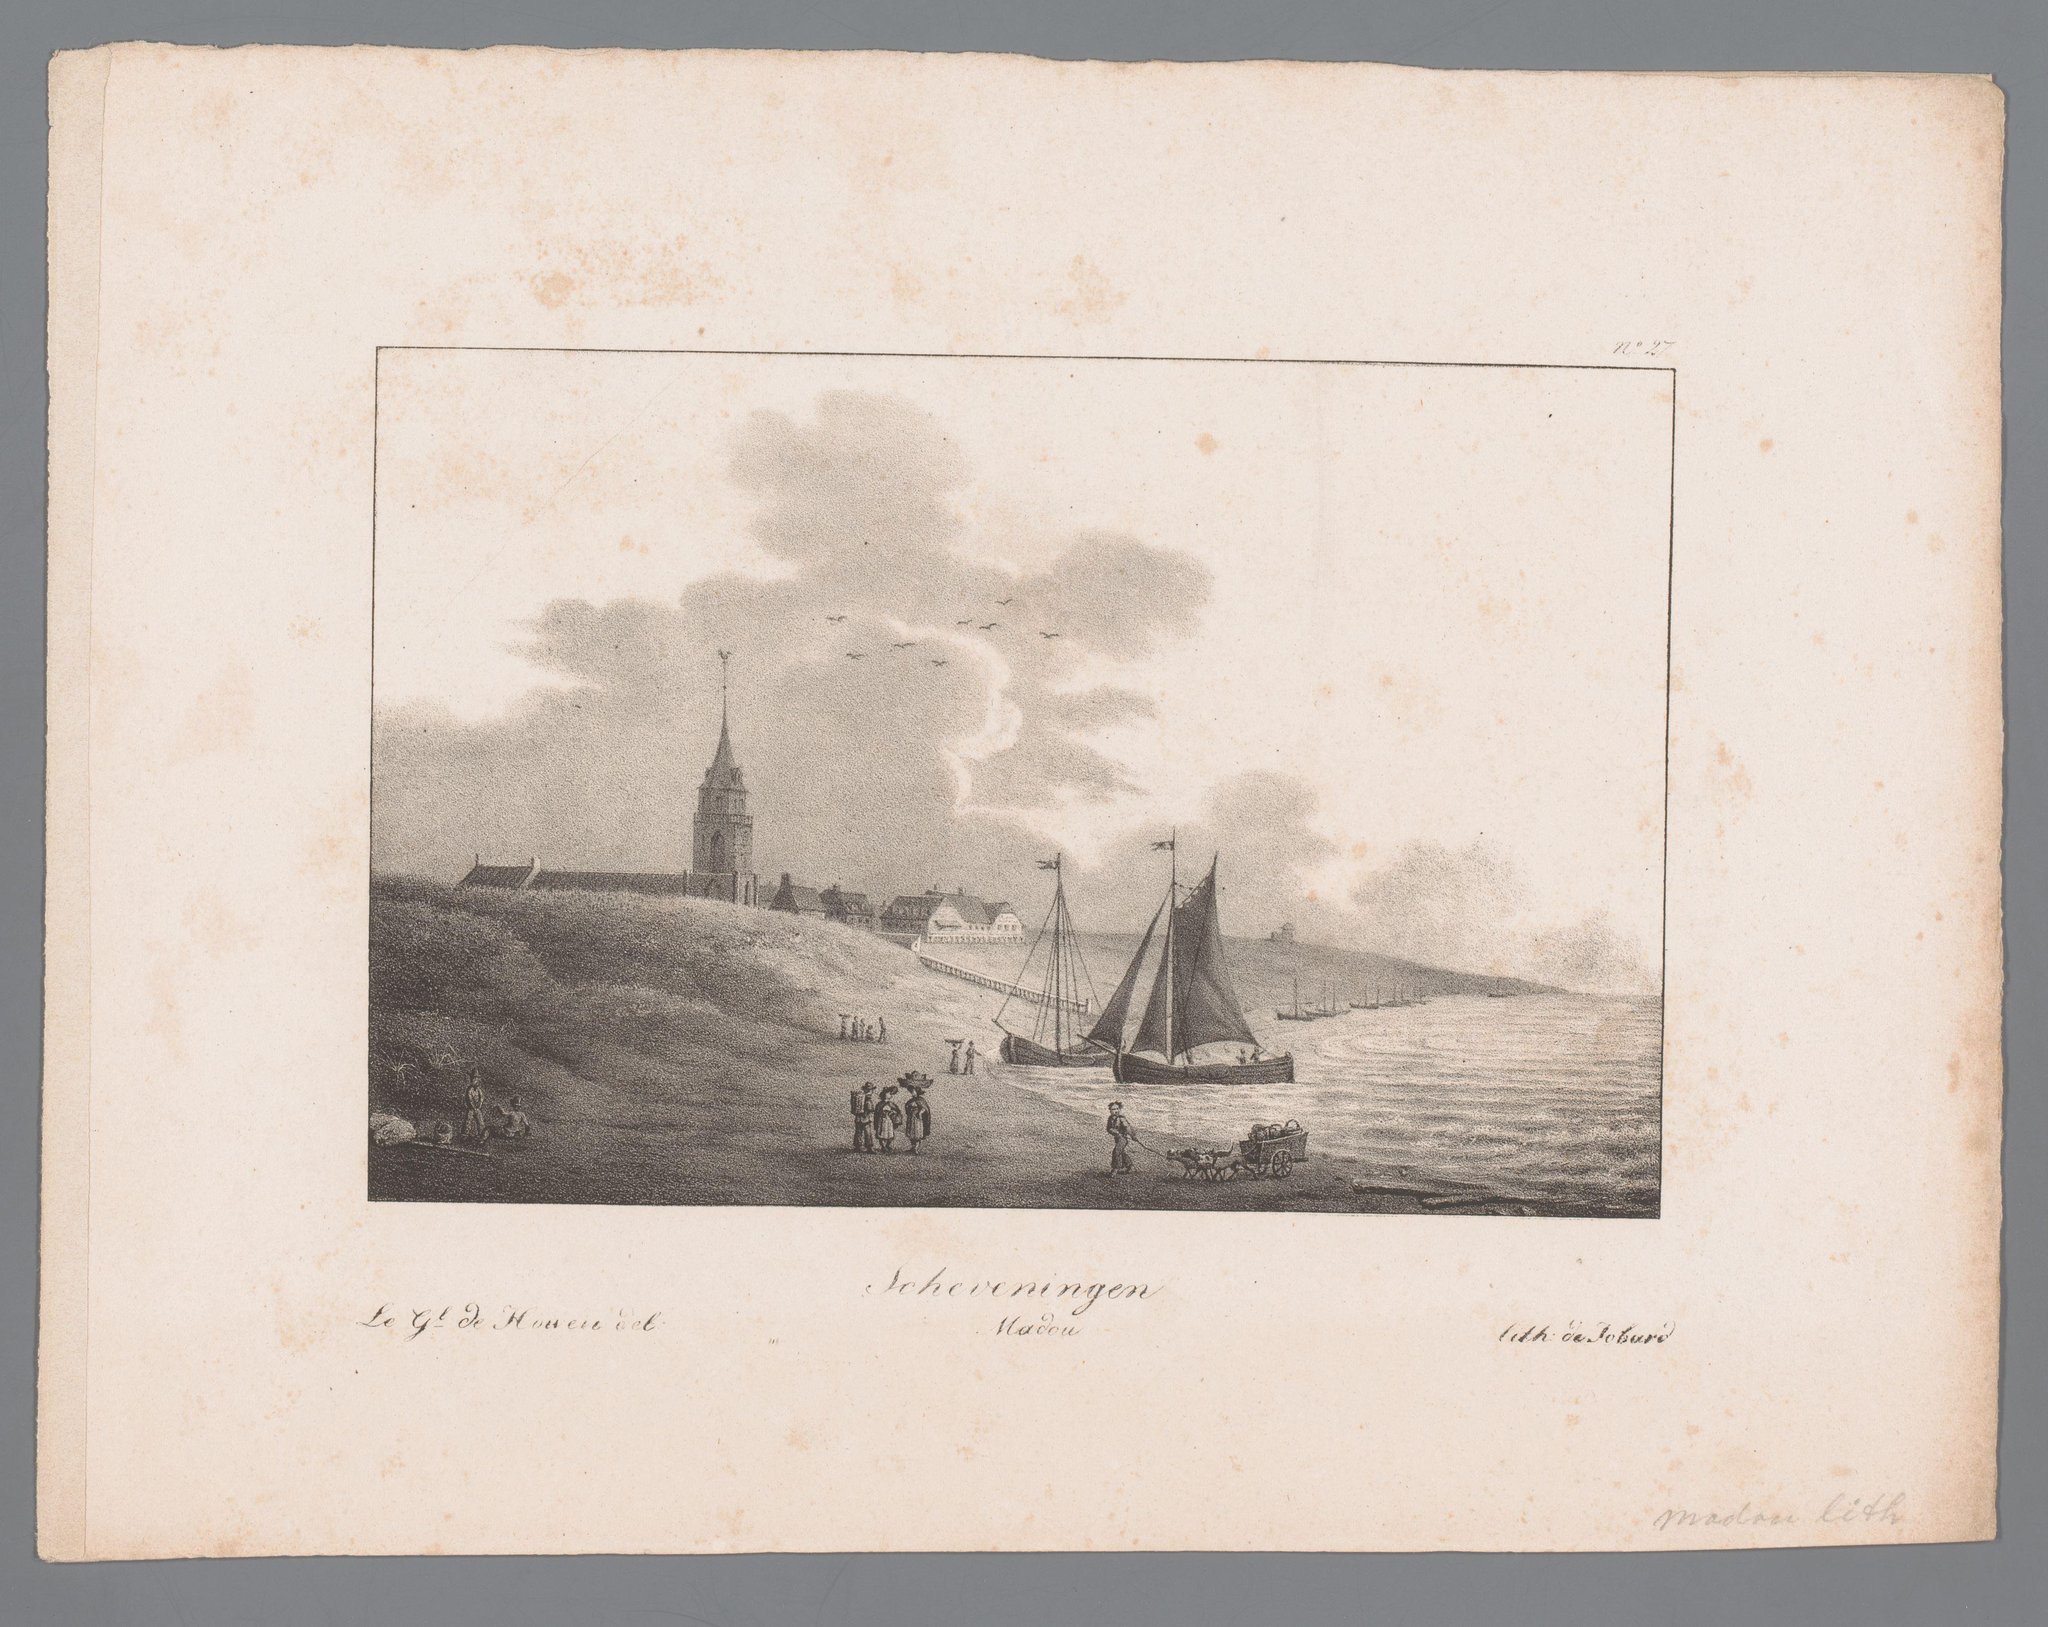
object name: print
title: Gezicht op Scheveningen vanaf het strand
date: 1825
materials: paper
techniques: lithograph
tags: prospect of village, silhouette of village, beach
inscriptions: collector's mark: Lugt 2228, collector's mark: Lugt 2760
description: Prent verschenen in: De Cloet, Jean. Voyage pittoresque dans le royaume des Pays Bas. Brussel: Jean Baptiste Ambroise Marcellin Jobard, 1825. Deze publicatie bevat 102 litho's, die in afleveringen verschenen als illustratie bij de tekst.